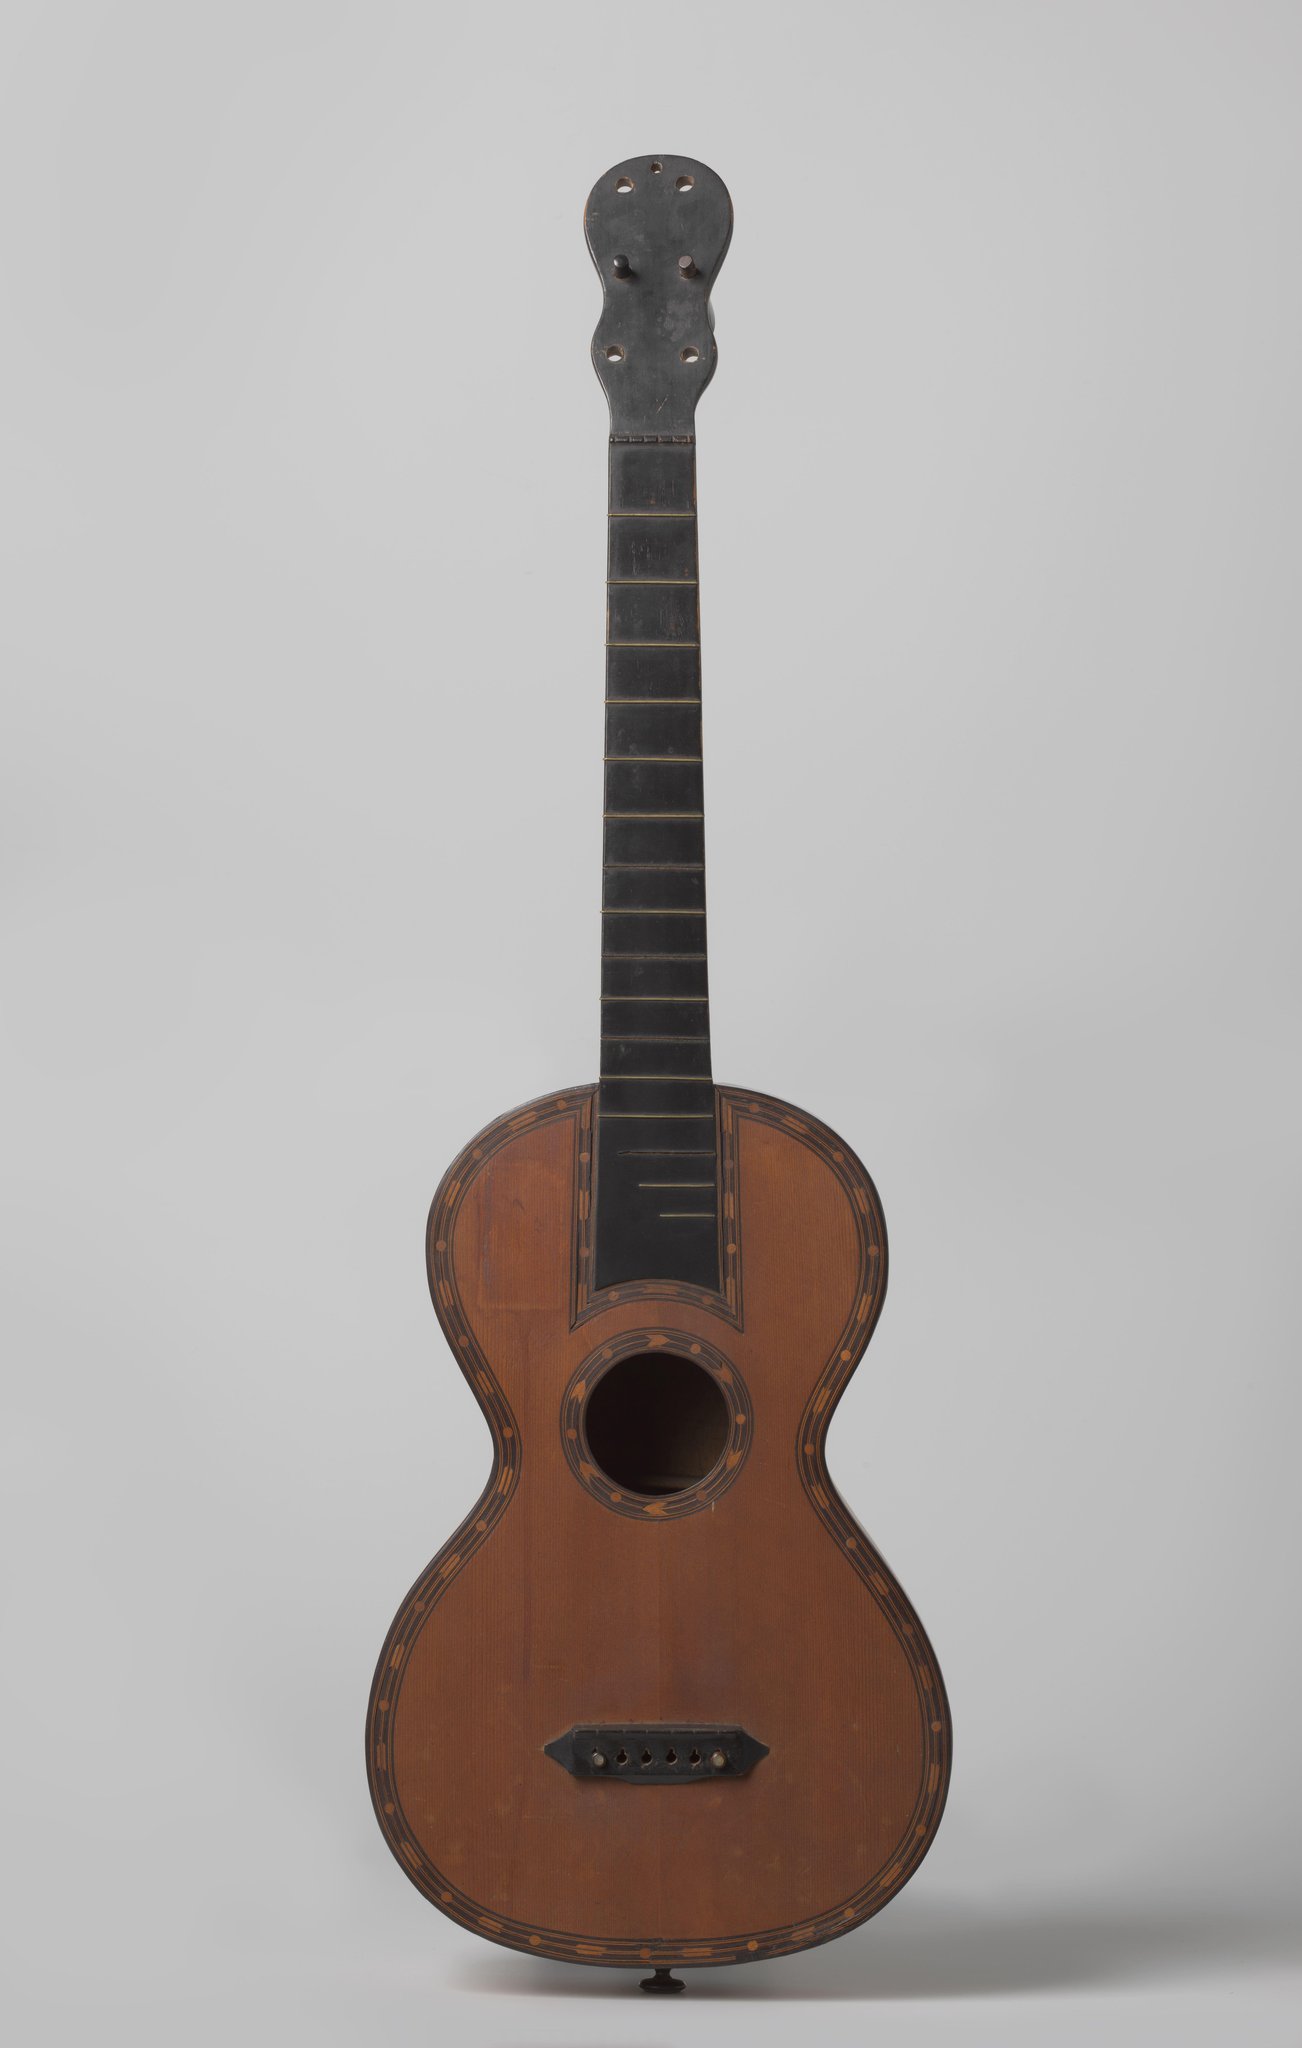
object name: guitar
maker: Anonymous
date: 1830-1850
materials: wood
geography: france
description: Gitaar met ingelegde randen. Er ontbreekt een schroef.